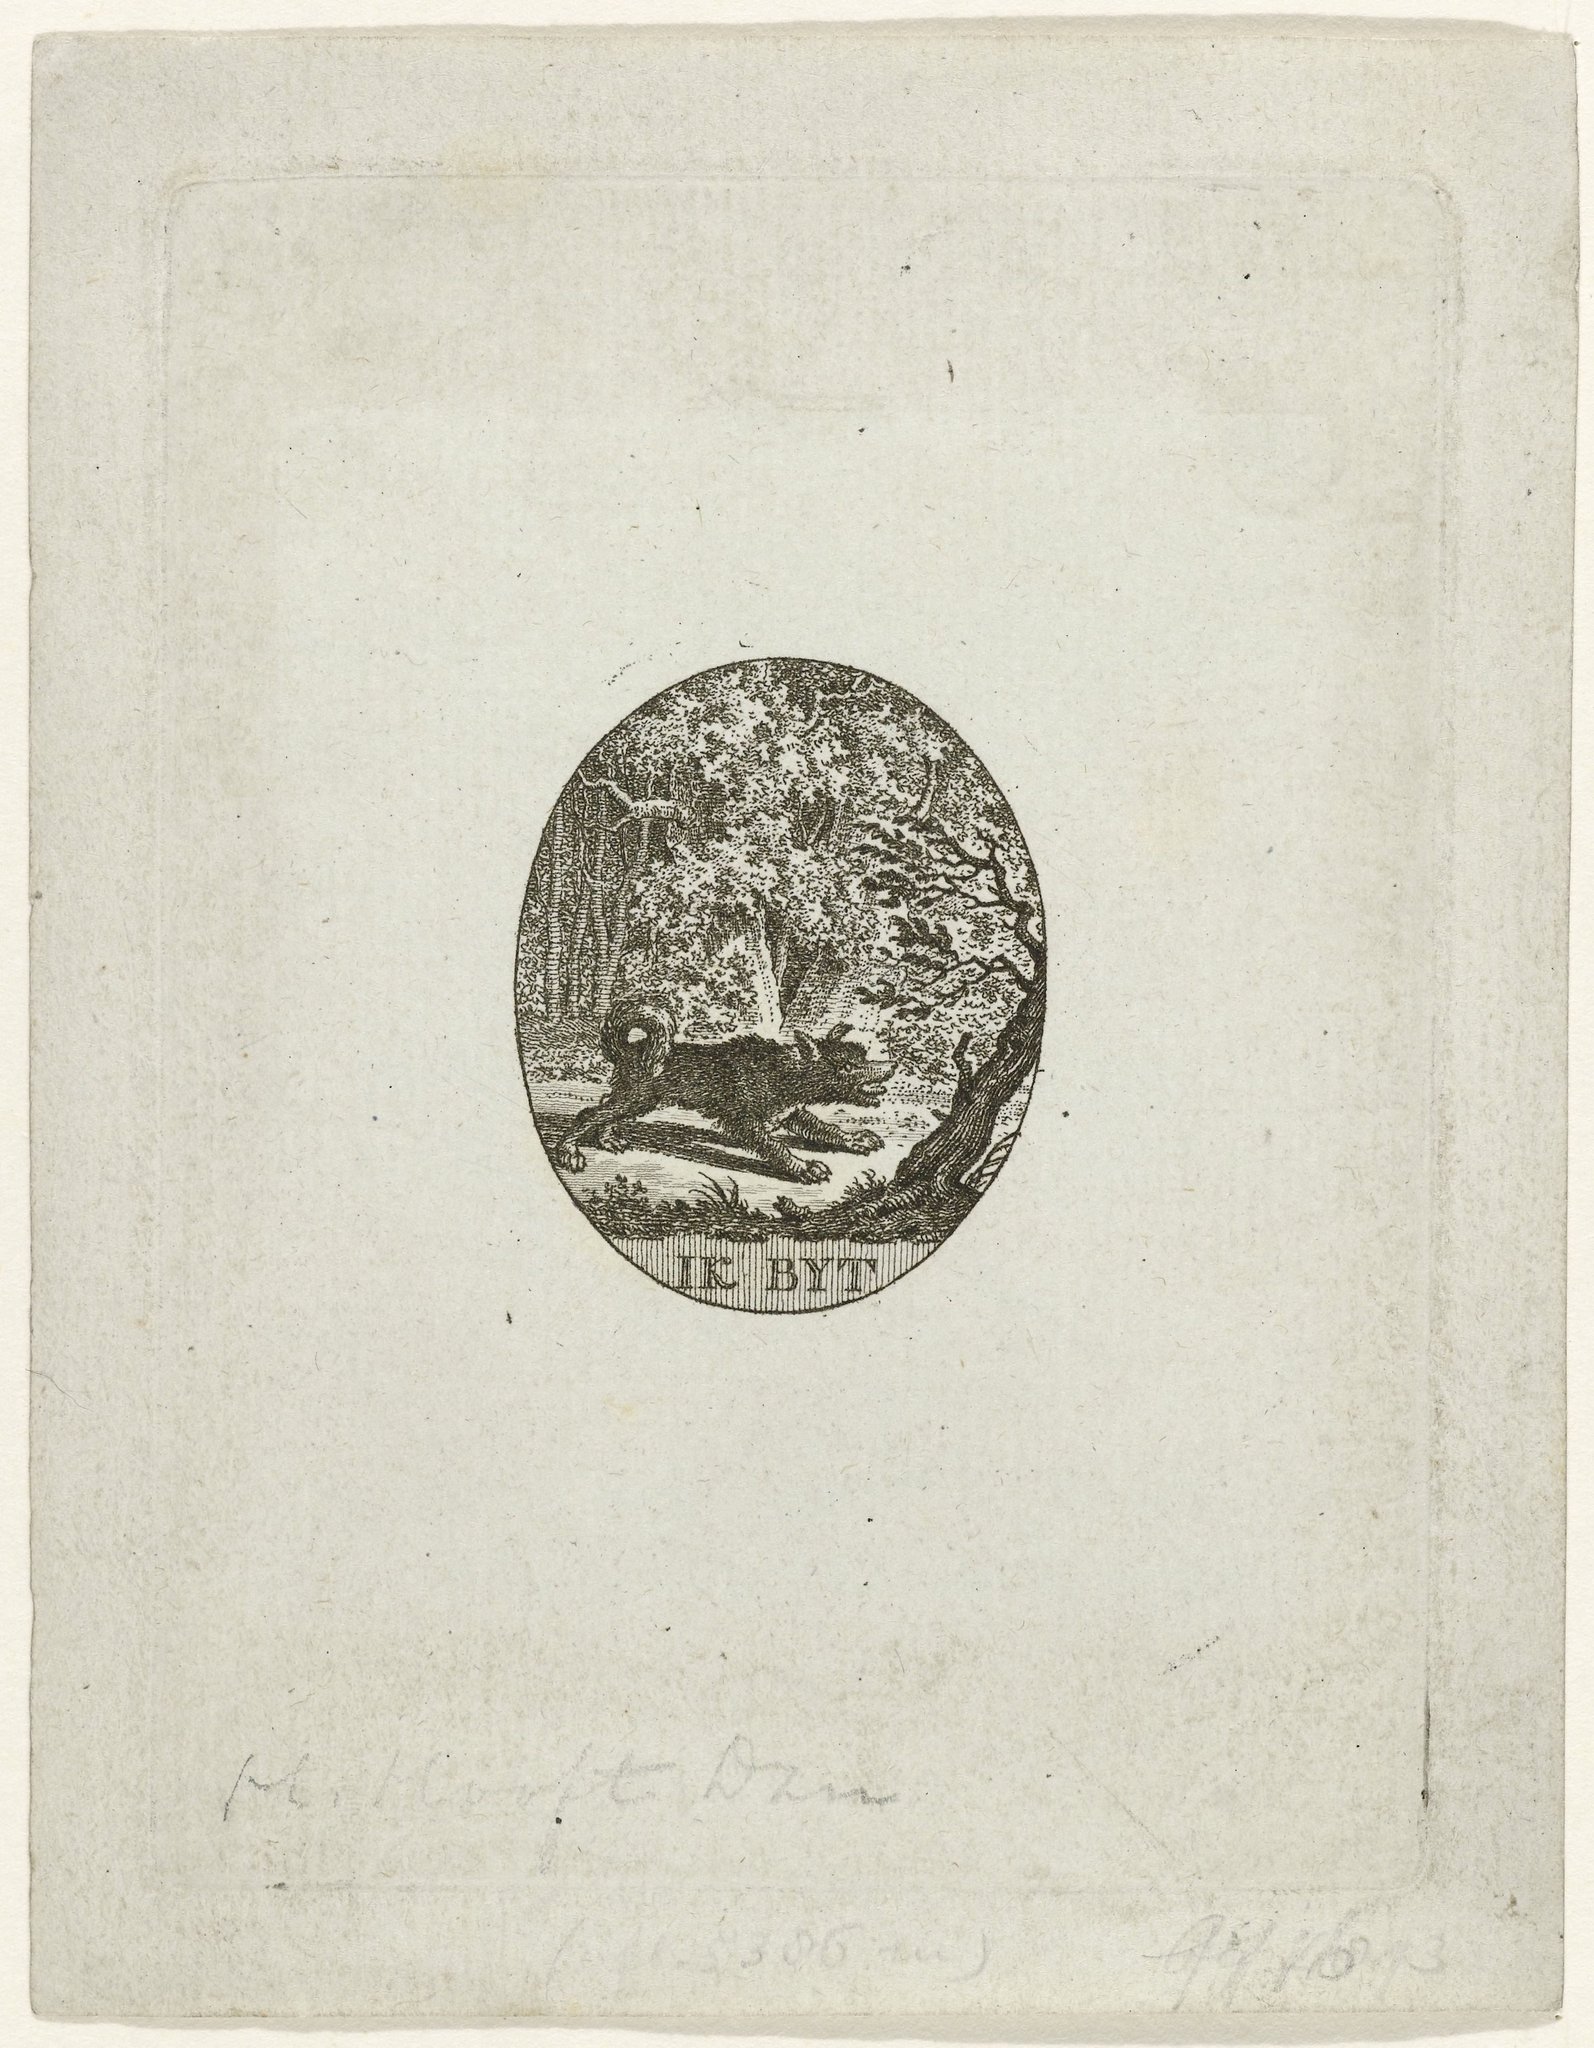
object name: print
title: Blaffende keeshond, ca. 1787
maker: Anonymous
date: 1787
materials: paper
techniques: etching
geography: northern netherlands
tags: dog, patriots (1780-1795)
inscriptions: collector's mark: Lugt 2228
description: Een blaffende naar rechts gewende keeshond in een bos, in ovaal, ca. 1787. Met als onderschrift "Ik bijt".